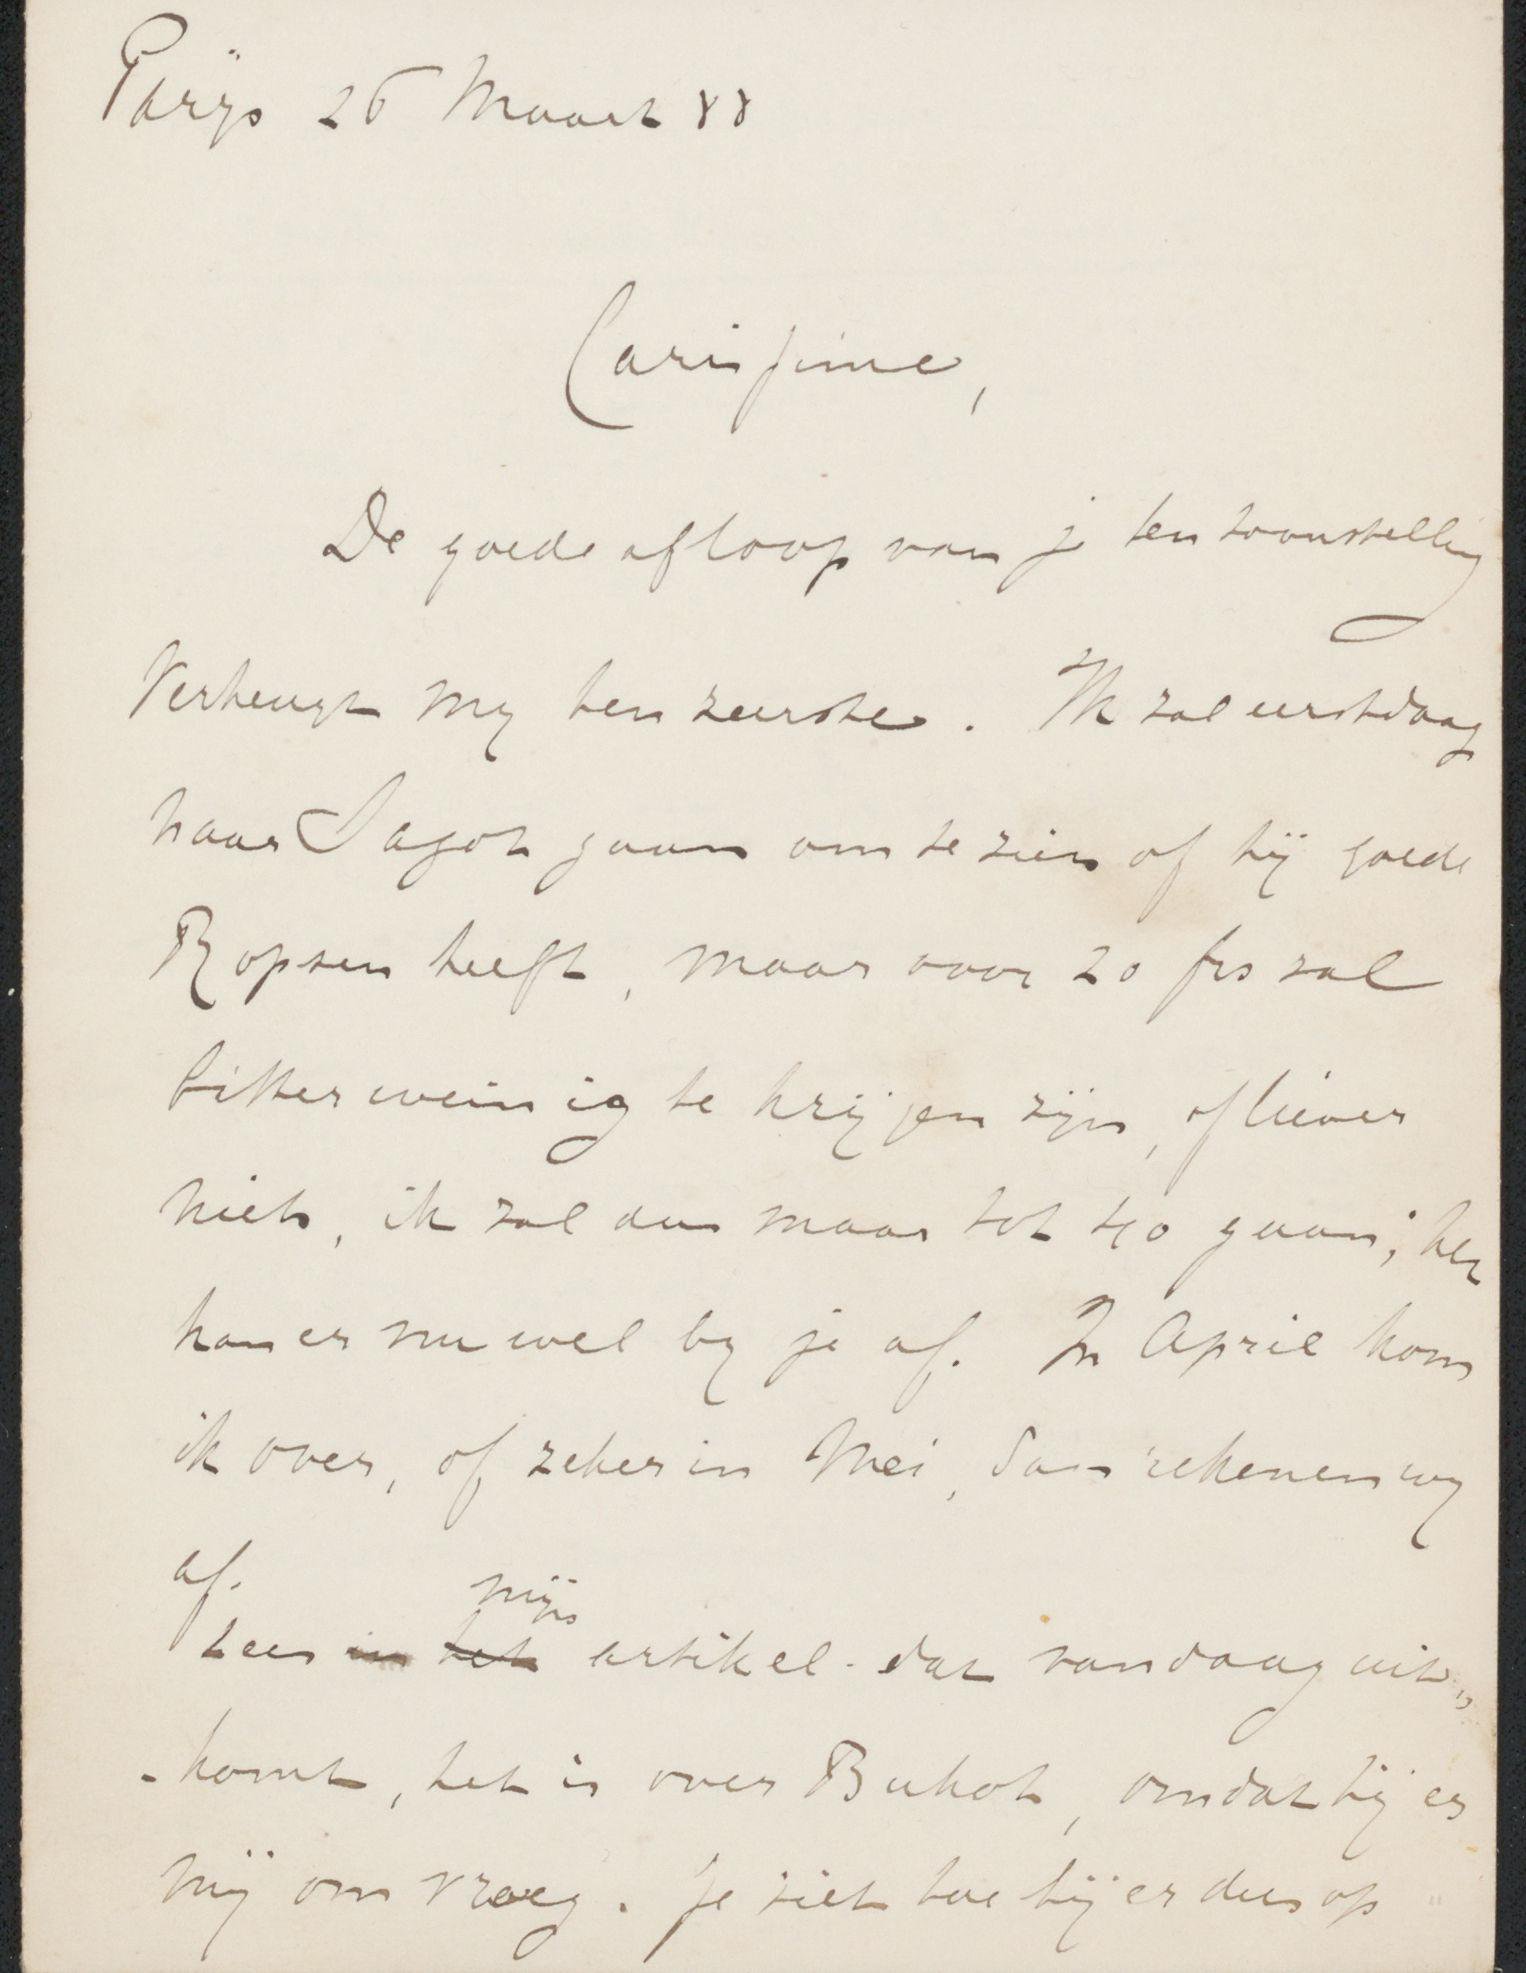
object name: letter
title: Brief aan Philip Zilcken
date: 1888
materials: ink, paper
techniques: pen, writing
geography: paris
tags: jonkheer victor eugène louis de stuers, marinus van der maarel, maastricht, amsterdam, engineer, jonkheer barthold willem floris van riemsdijk, rotterdam, frederik daniel otto obreen, paris, print maker, draughtsman, félix hilaire buhot, abraham bredius, publisher, edmond sagot, félicien rops, utrecht, johan de meester, the hague, painter, philip zilcken, exhibition ~ art, money, printed matter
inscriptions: collector's mark: ‘RPK’